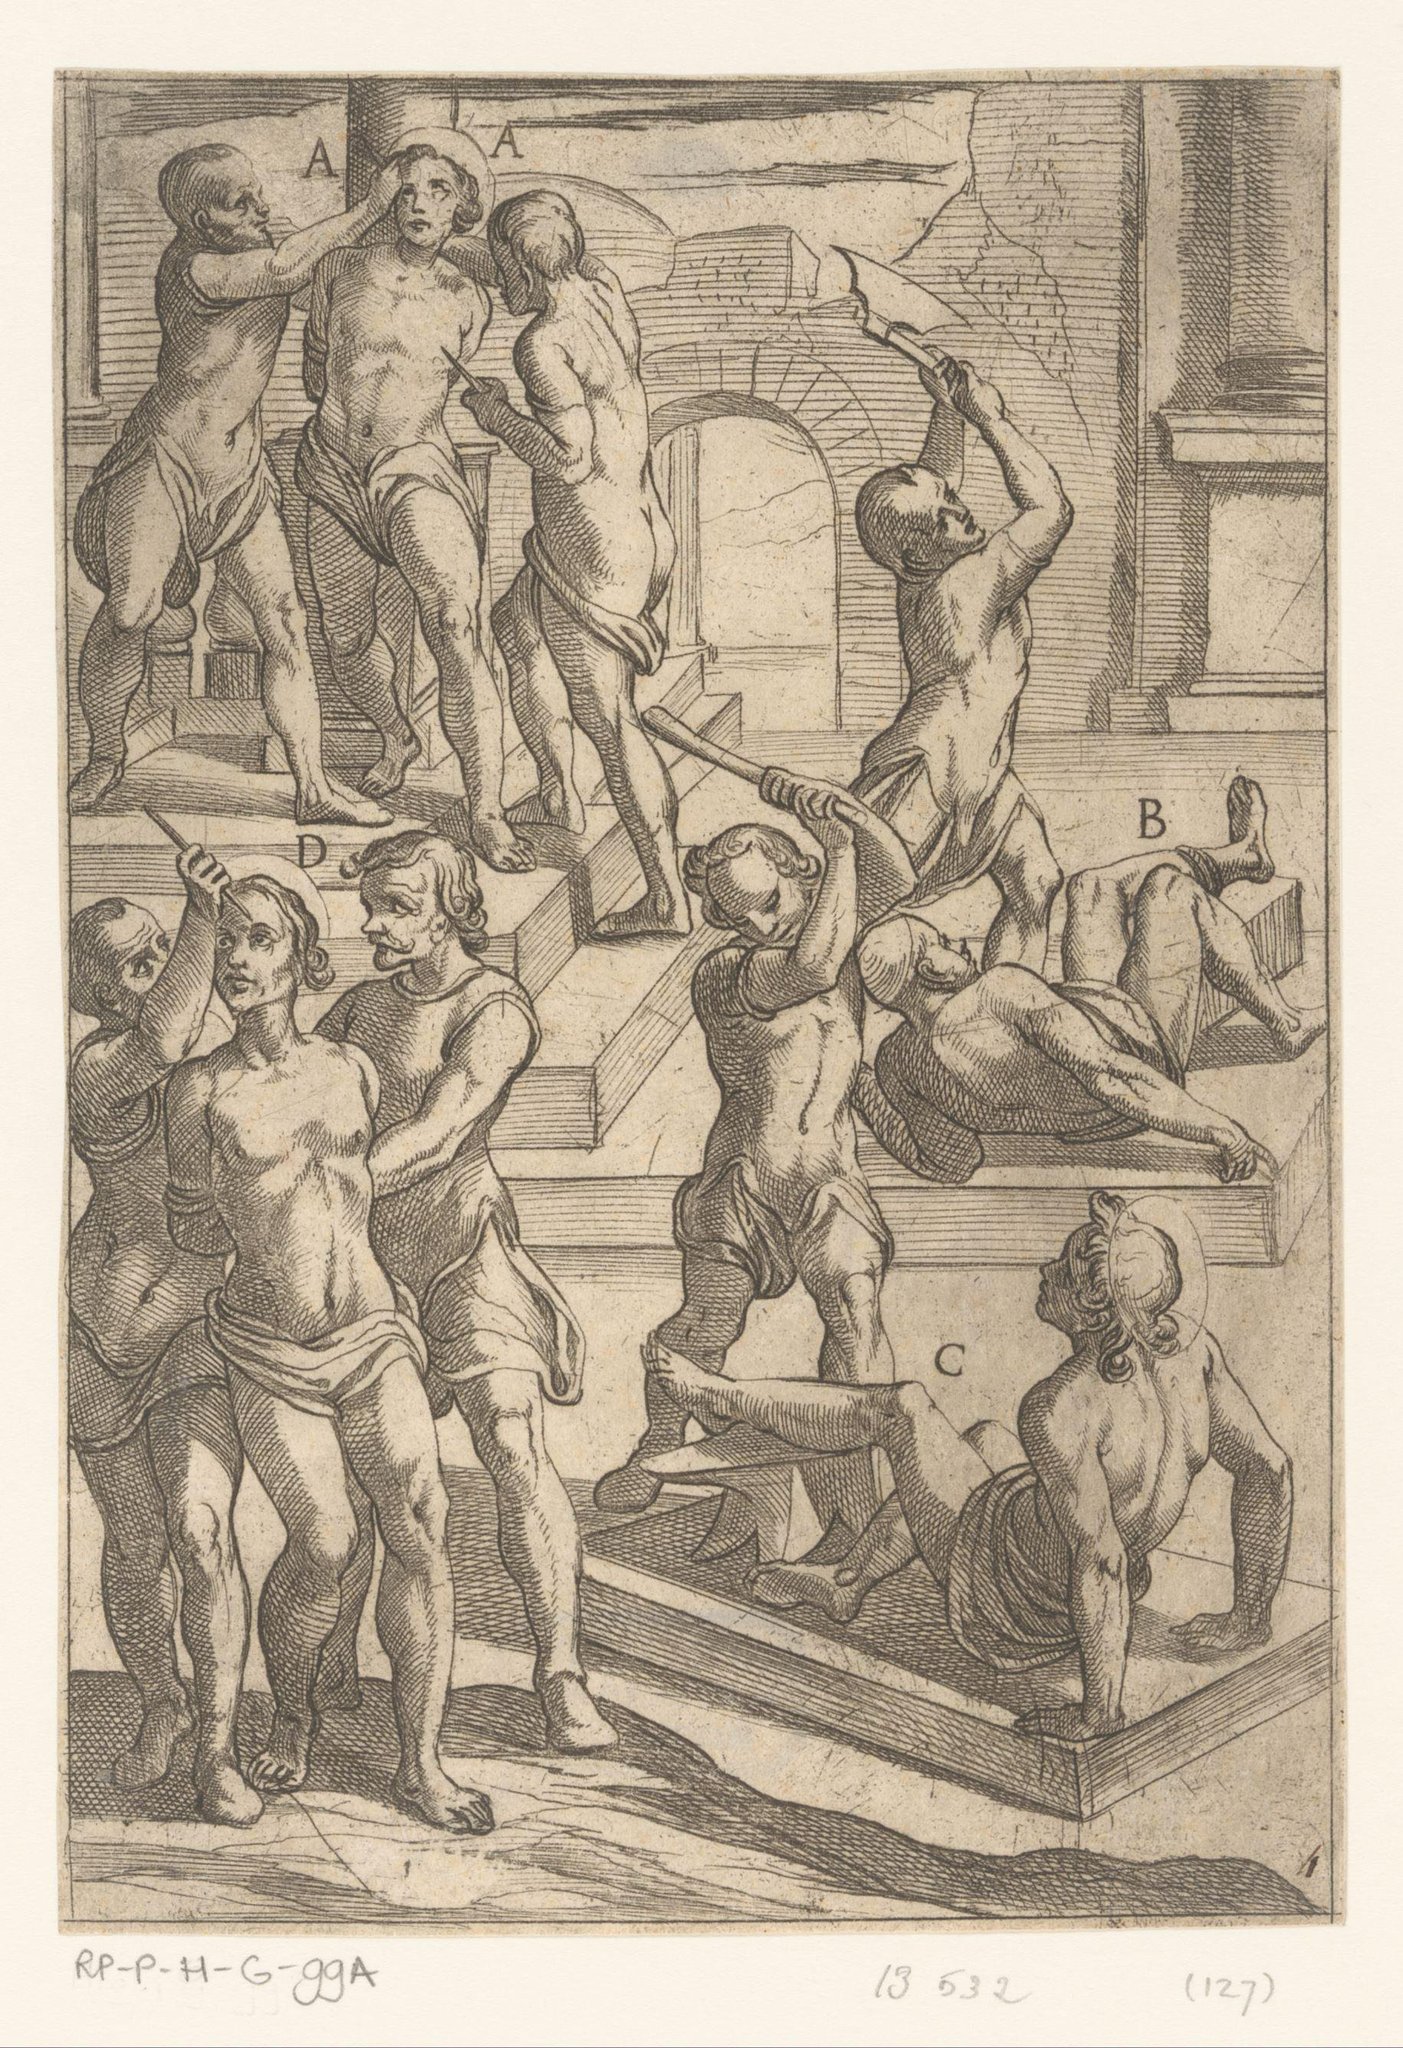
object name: print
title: Varia tormentorum et supplicioru crudelium (...)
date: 1565-1630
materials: paper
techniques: etching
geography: italy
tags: violent death ~ maltreatment, torture, torture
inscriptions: collector's mark: ‘Hinloopen’, number: ‘4’, collector's mark: Lugt 11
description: Deze prent maakt deel uit van een reeks van 47 prenten (+ titelprent) met voorstellingen van martelmethoden. Deze prenten zijn in een andere editie gebruikt als illustraties voor Antonio Gallonio's 'Trattato degli Instrumenti di Martirio e delle Varie Maniere di Martoriare Usate dai Gentili contro Christiani' (Rome, Ascanio en Girolamo Dongangeli, 1591).